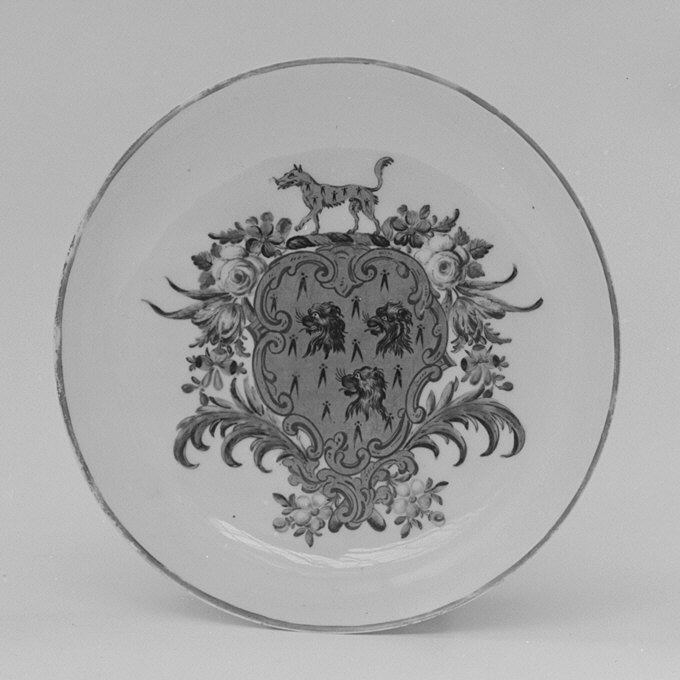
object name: saucer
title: Saucer (part of a service)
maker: james giles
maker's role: decorator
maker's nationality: british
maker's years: 1718-1780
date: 1760-1770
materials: hard paste porcelain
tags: animals,flowers,coat of arms